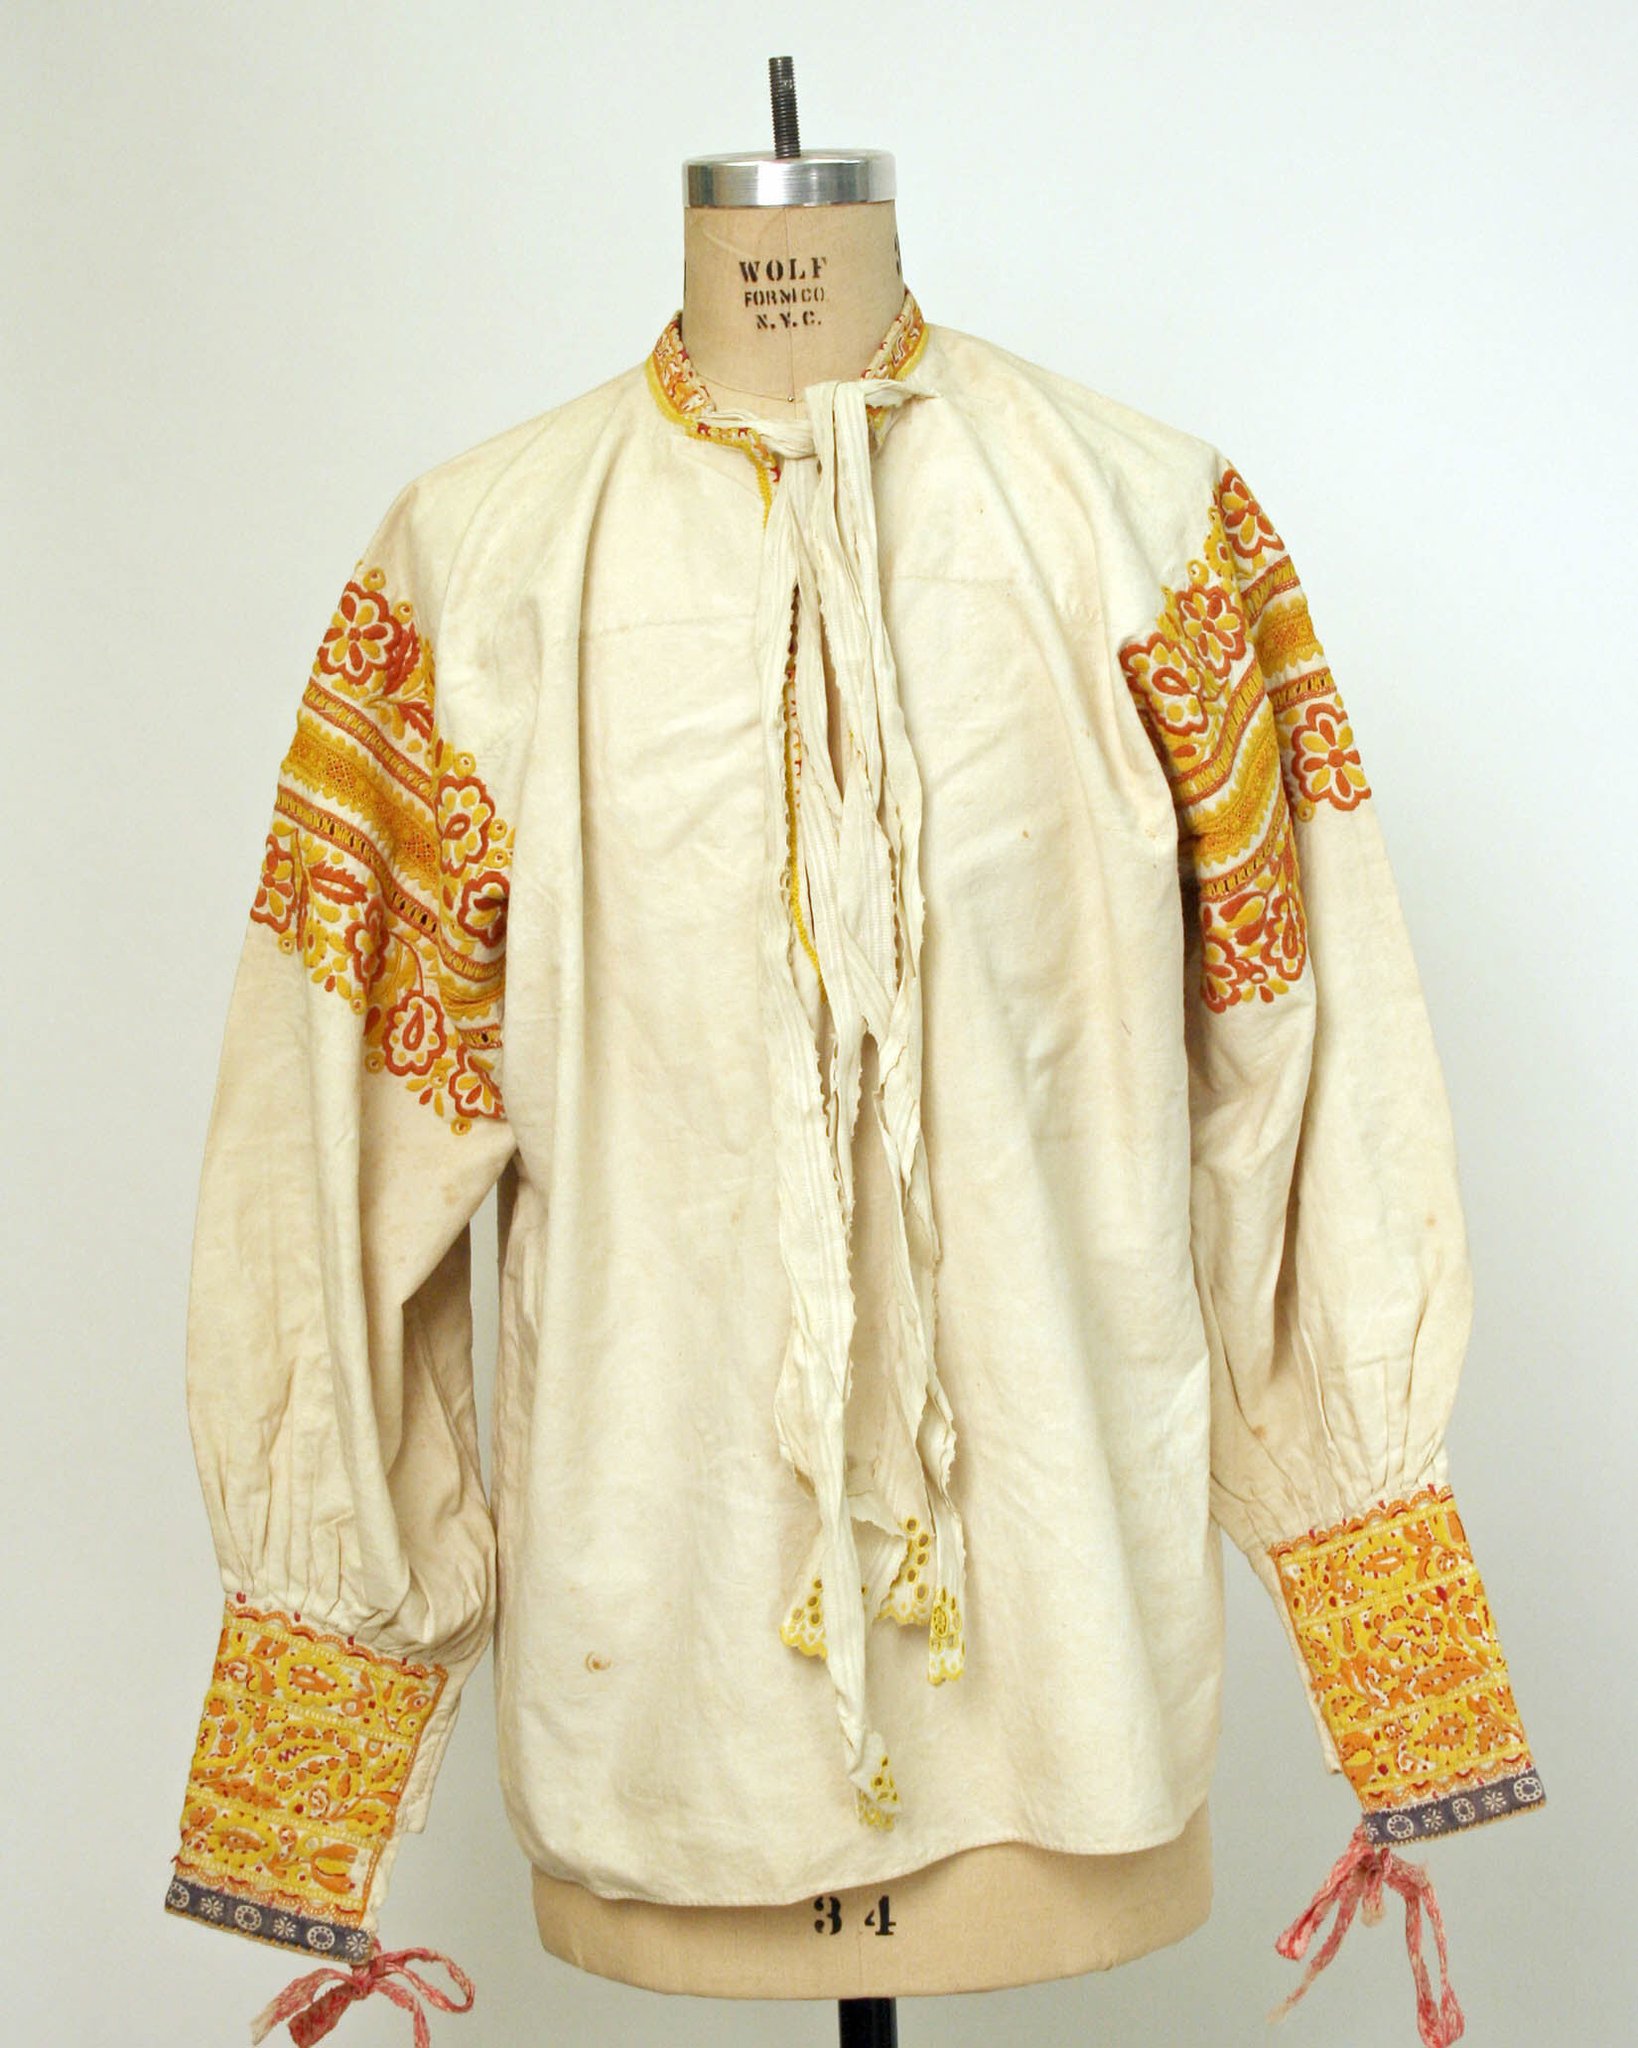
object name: shirt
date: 1801-1900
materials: cotton